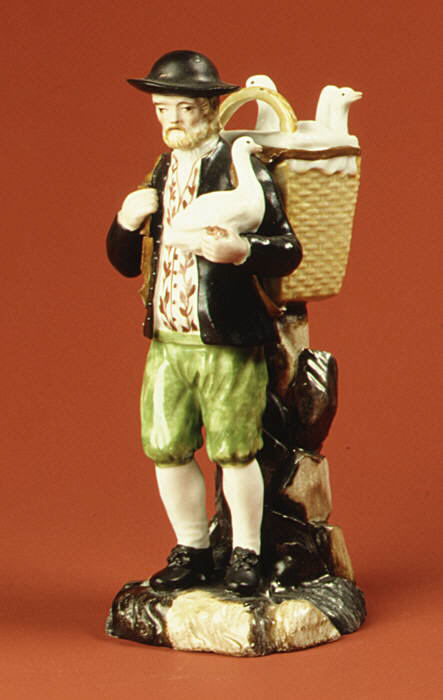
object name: figure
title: Goose Seller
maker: royal porcelain manufactory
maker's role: factory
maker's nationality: danish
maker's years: 1775-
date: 1780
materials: hard paste porcelain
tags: geese,men